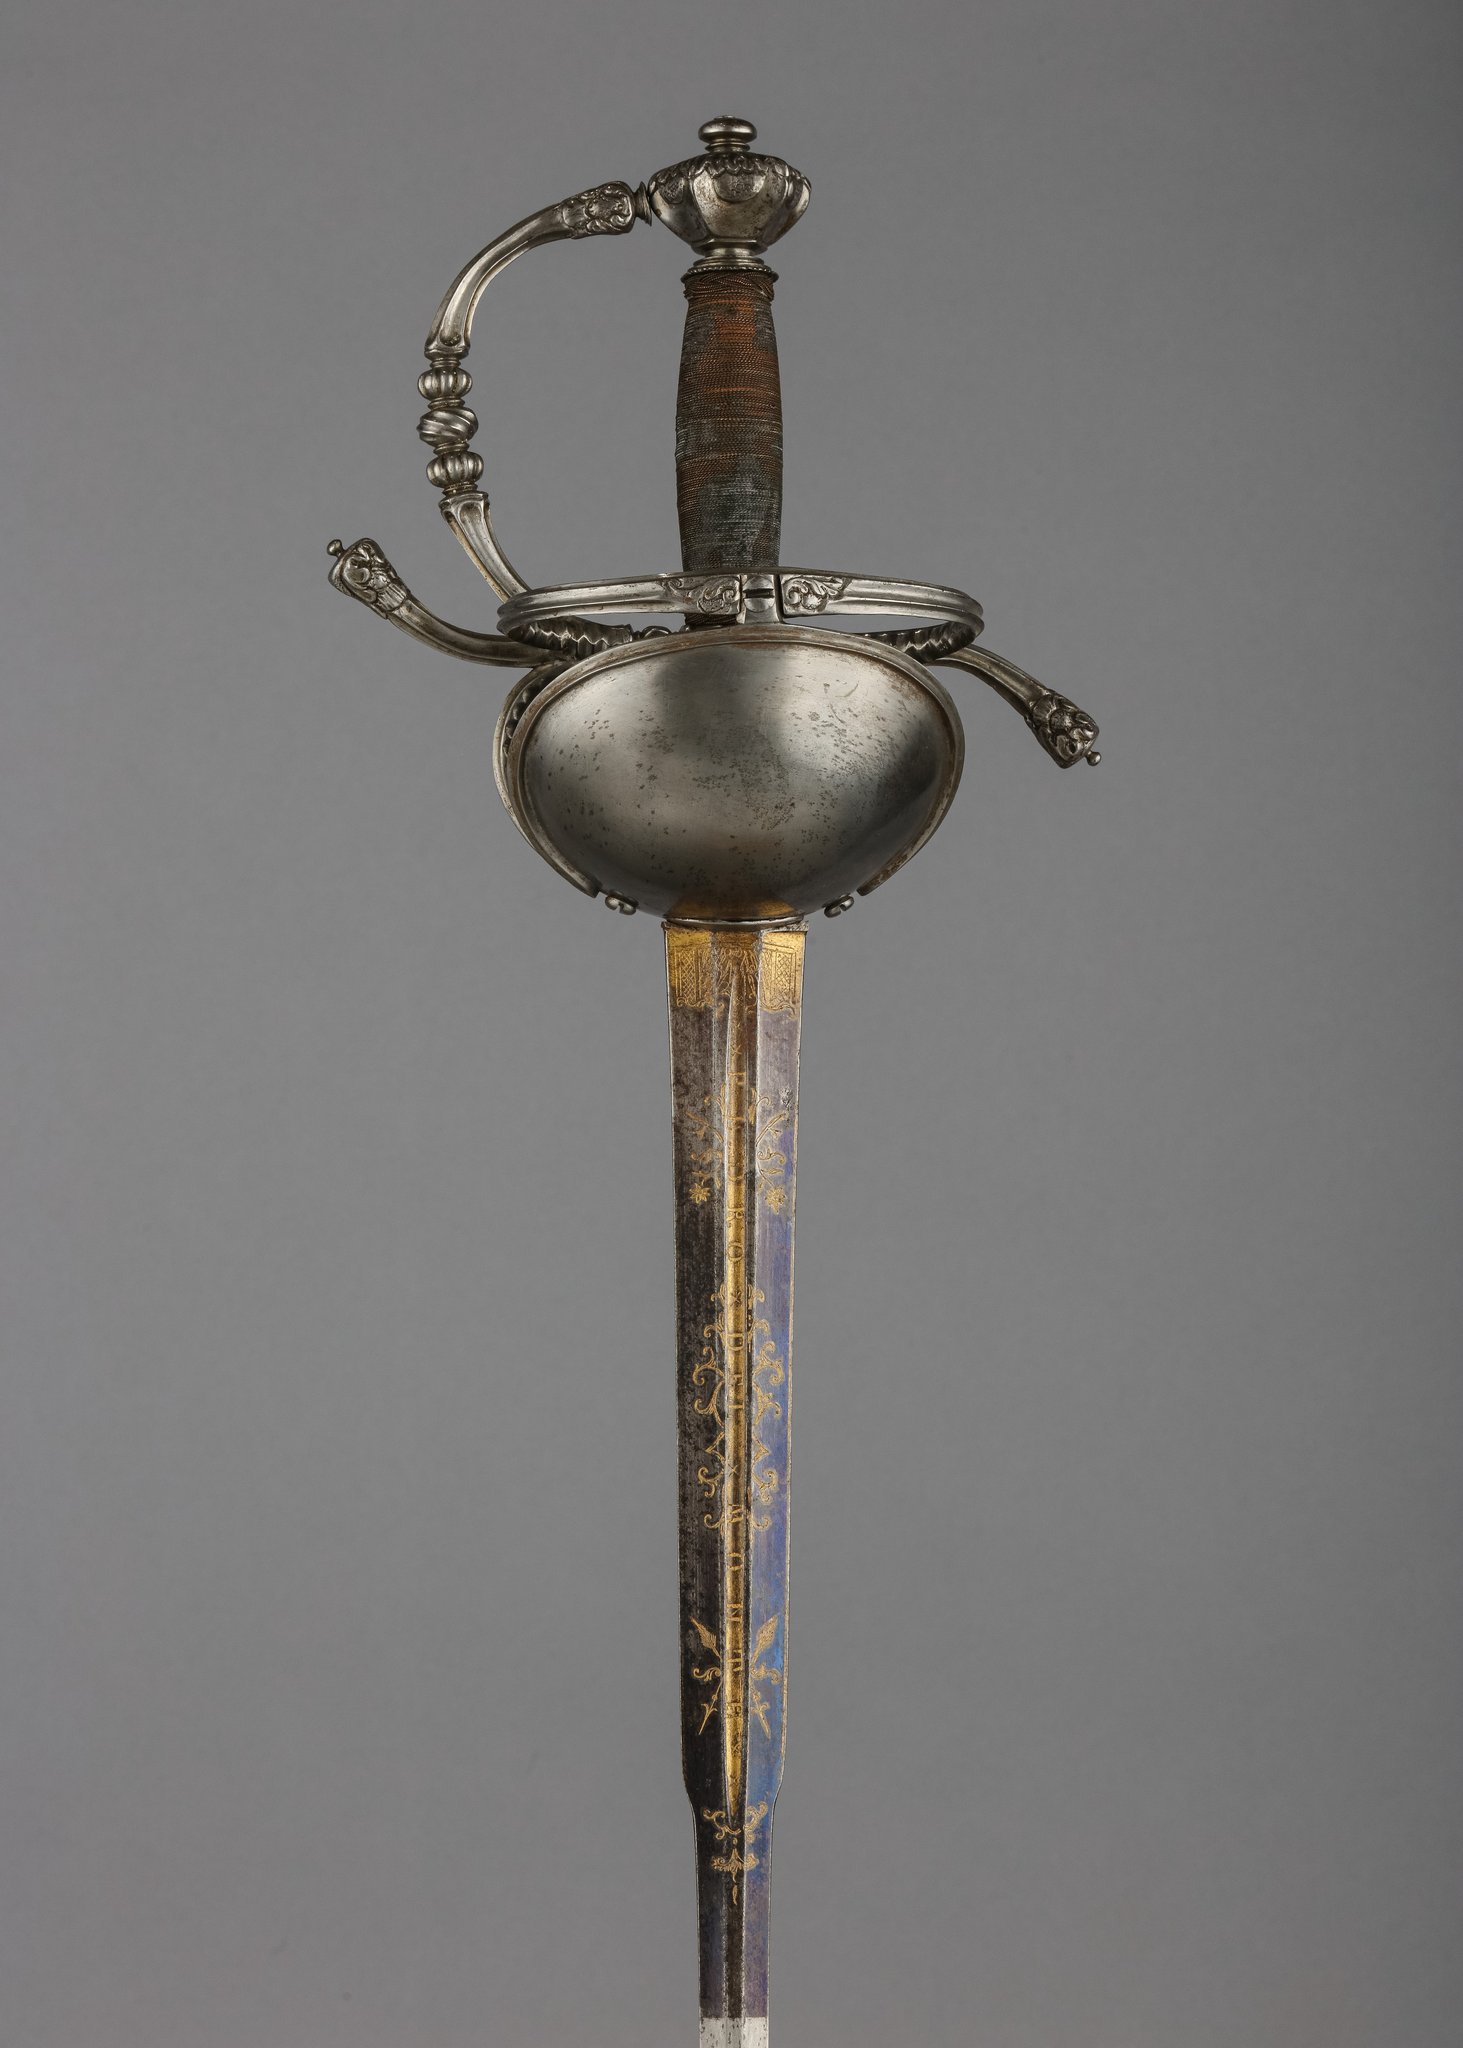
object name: rapier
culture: italian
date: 1700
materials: copper, gold, steel, metal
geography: italy